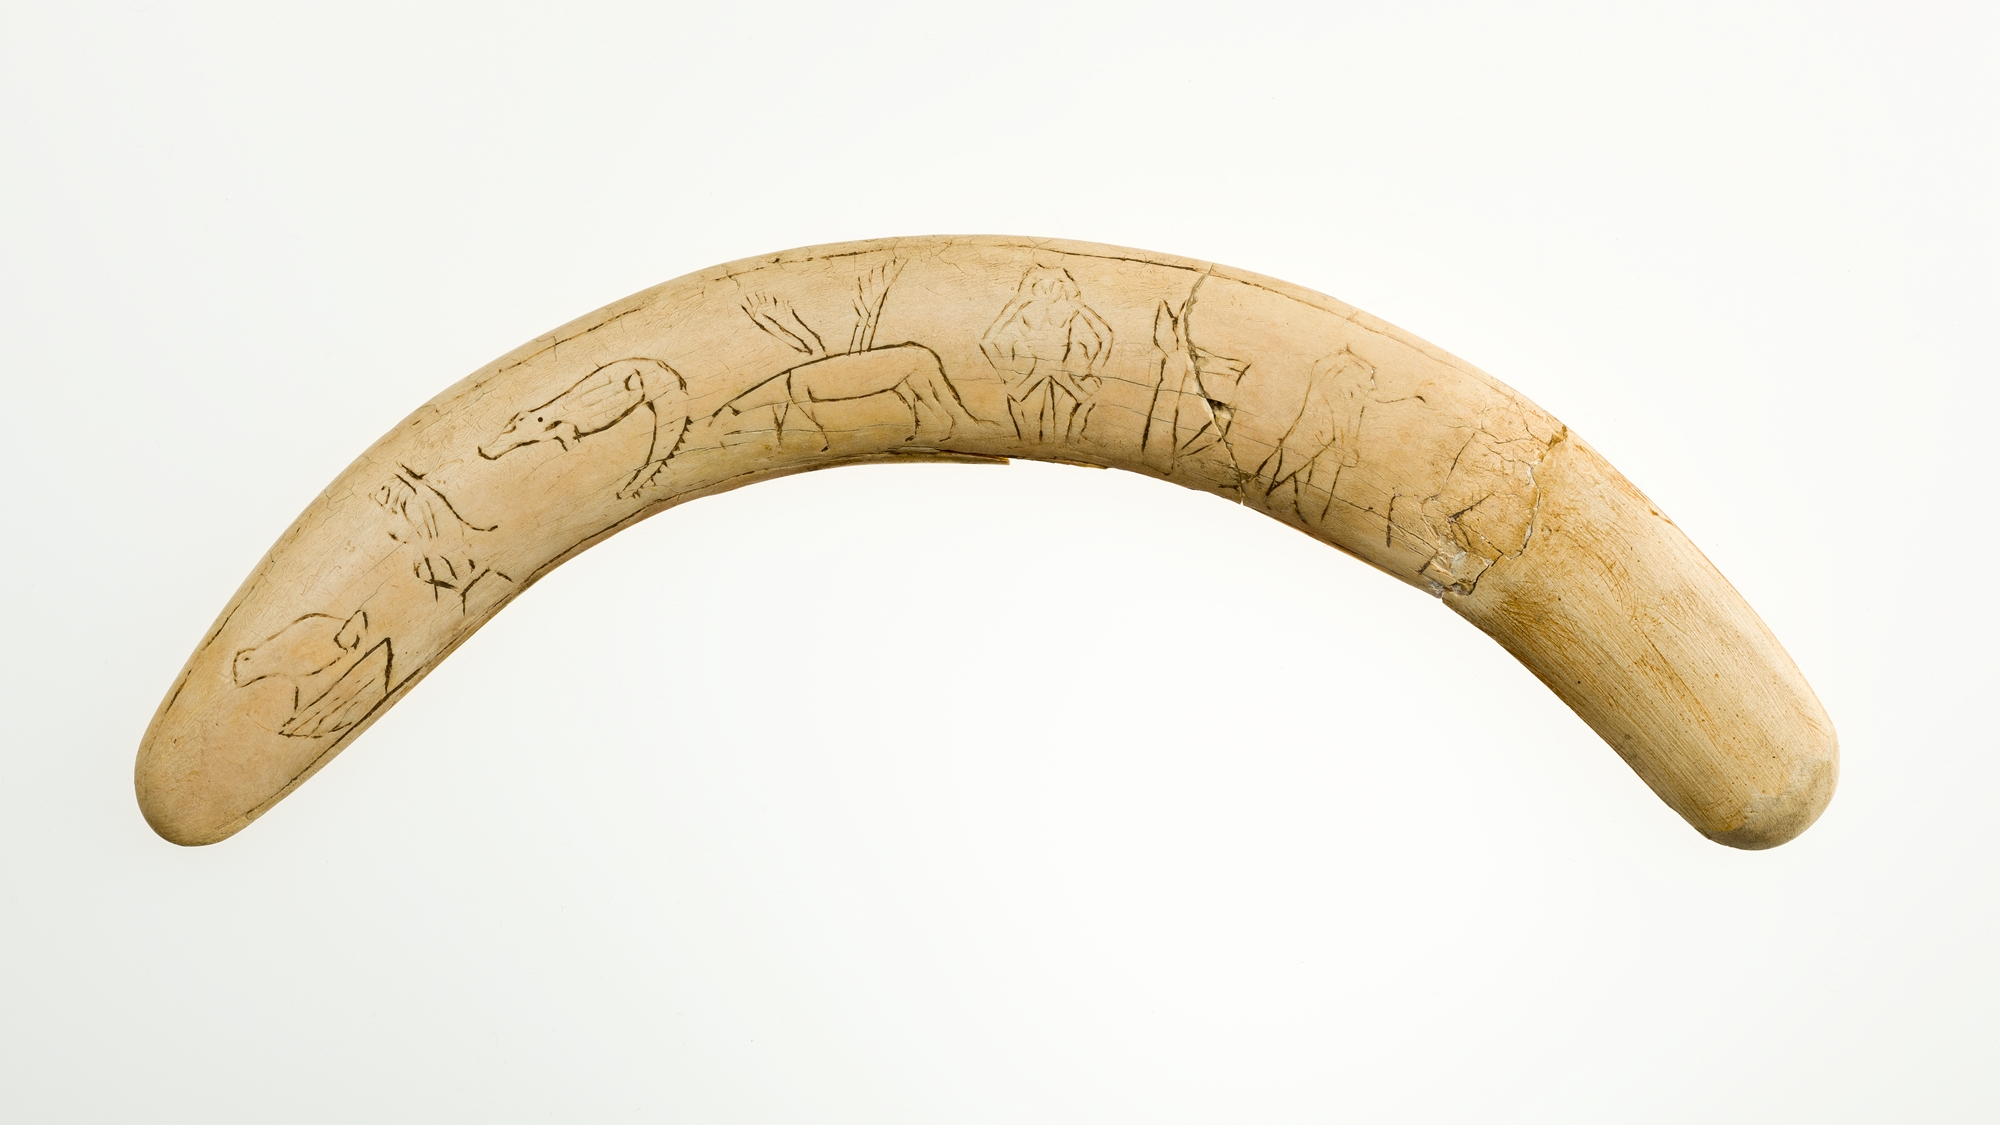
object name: magic wand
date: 1850-1640 BCE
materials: ivory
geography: egypt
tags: animals,crocodiles,frogs